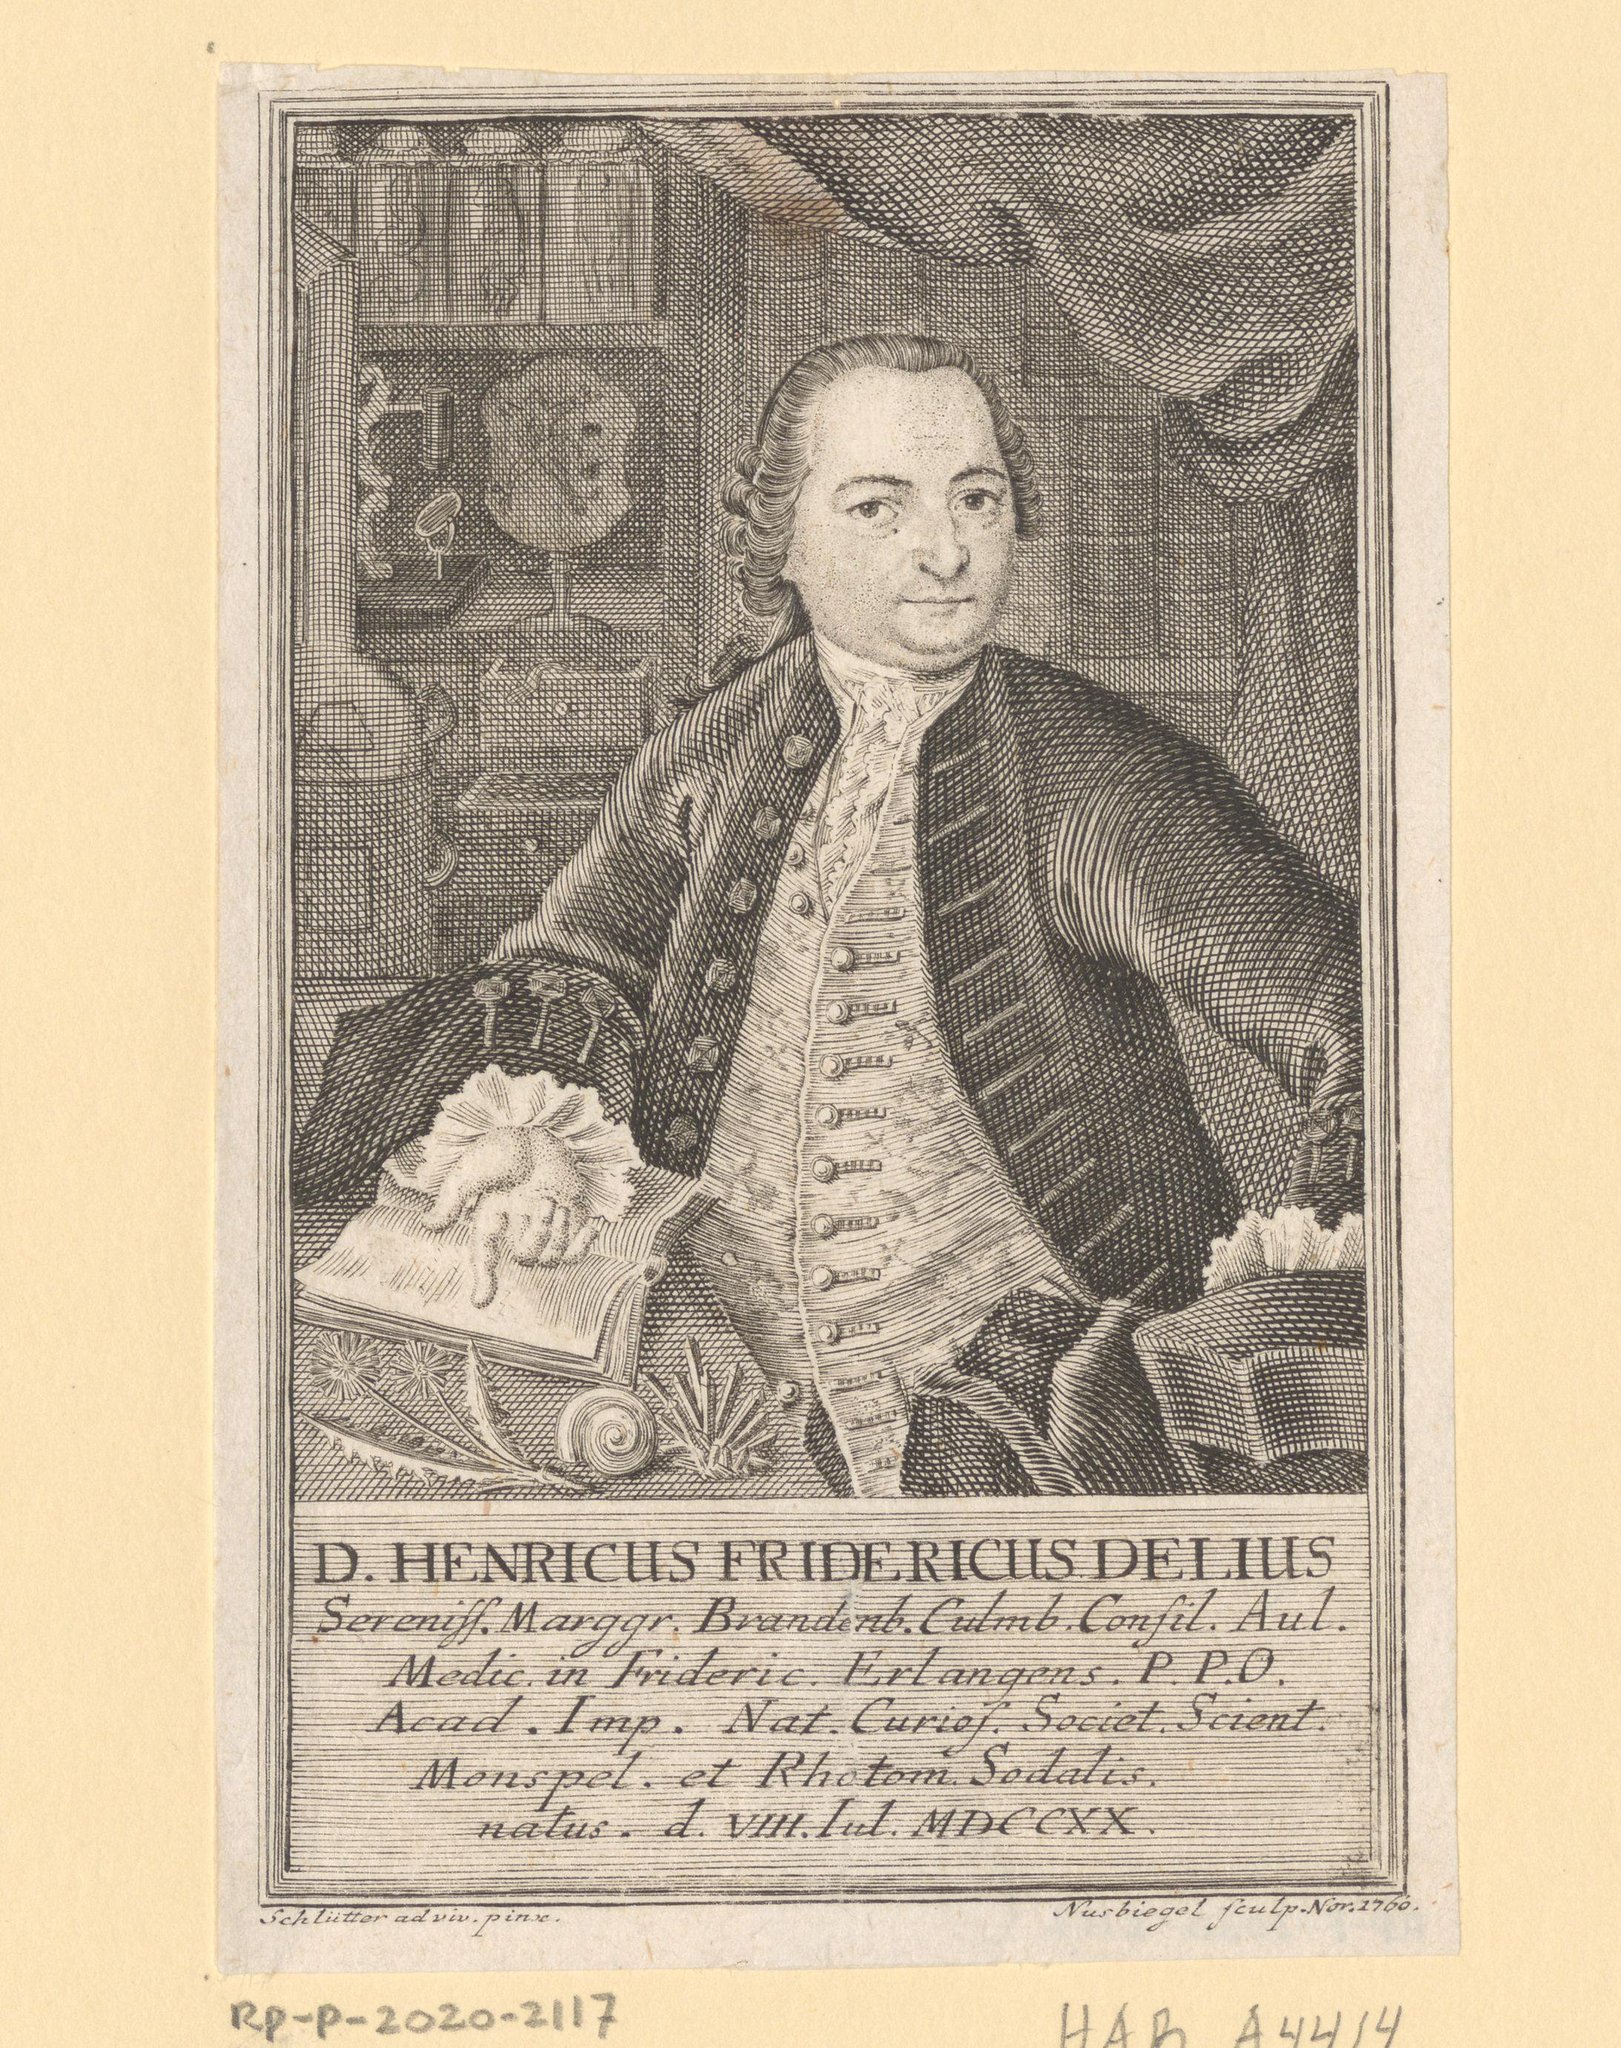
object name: print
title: Portret van Heinrich Friedrich von Delius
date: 1760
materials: paper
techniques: engraving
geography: nuremberg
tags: further education (+ portrait of teacher, professor), historical persons, physician, doctor